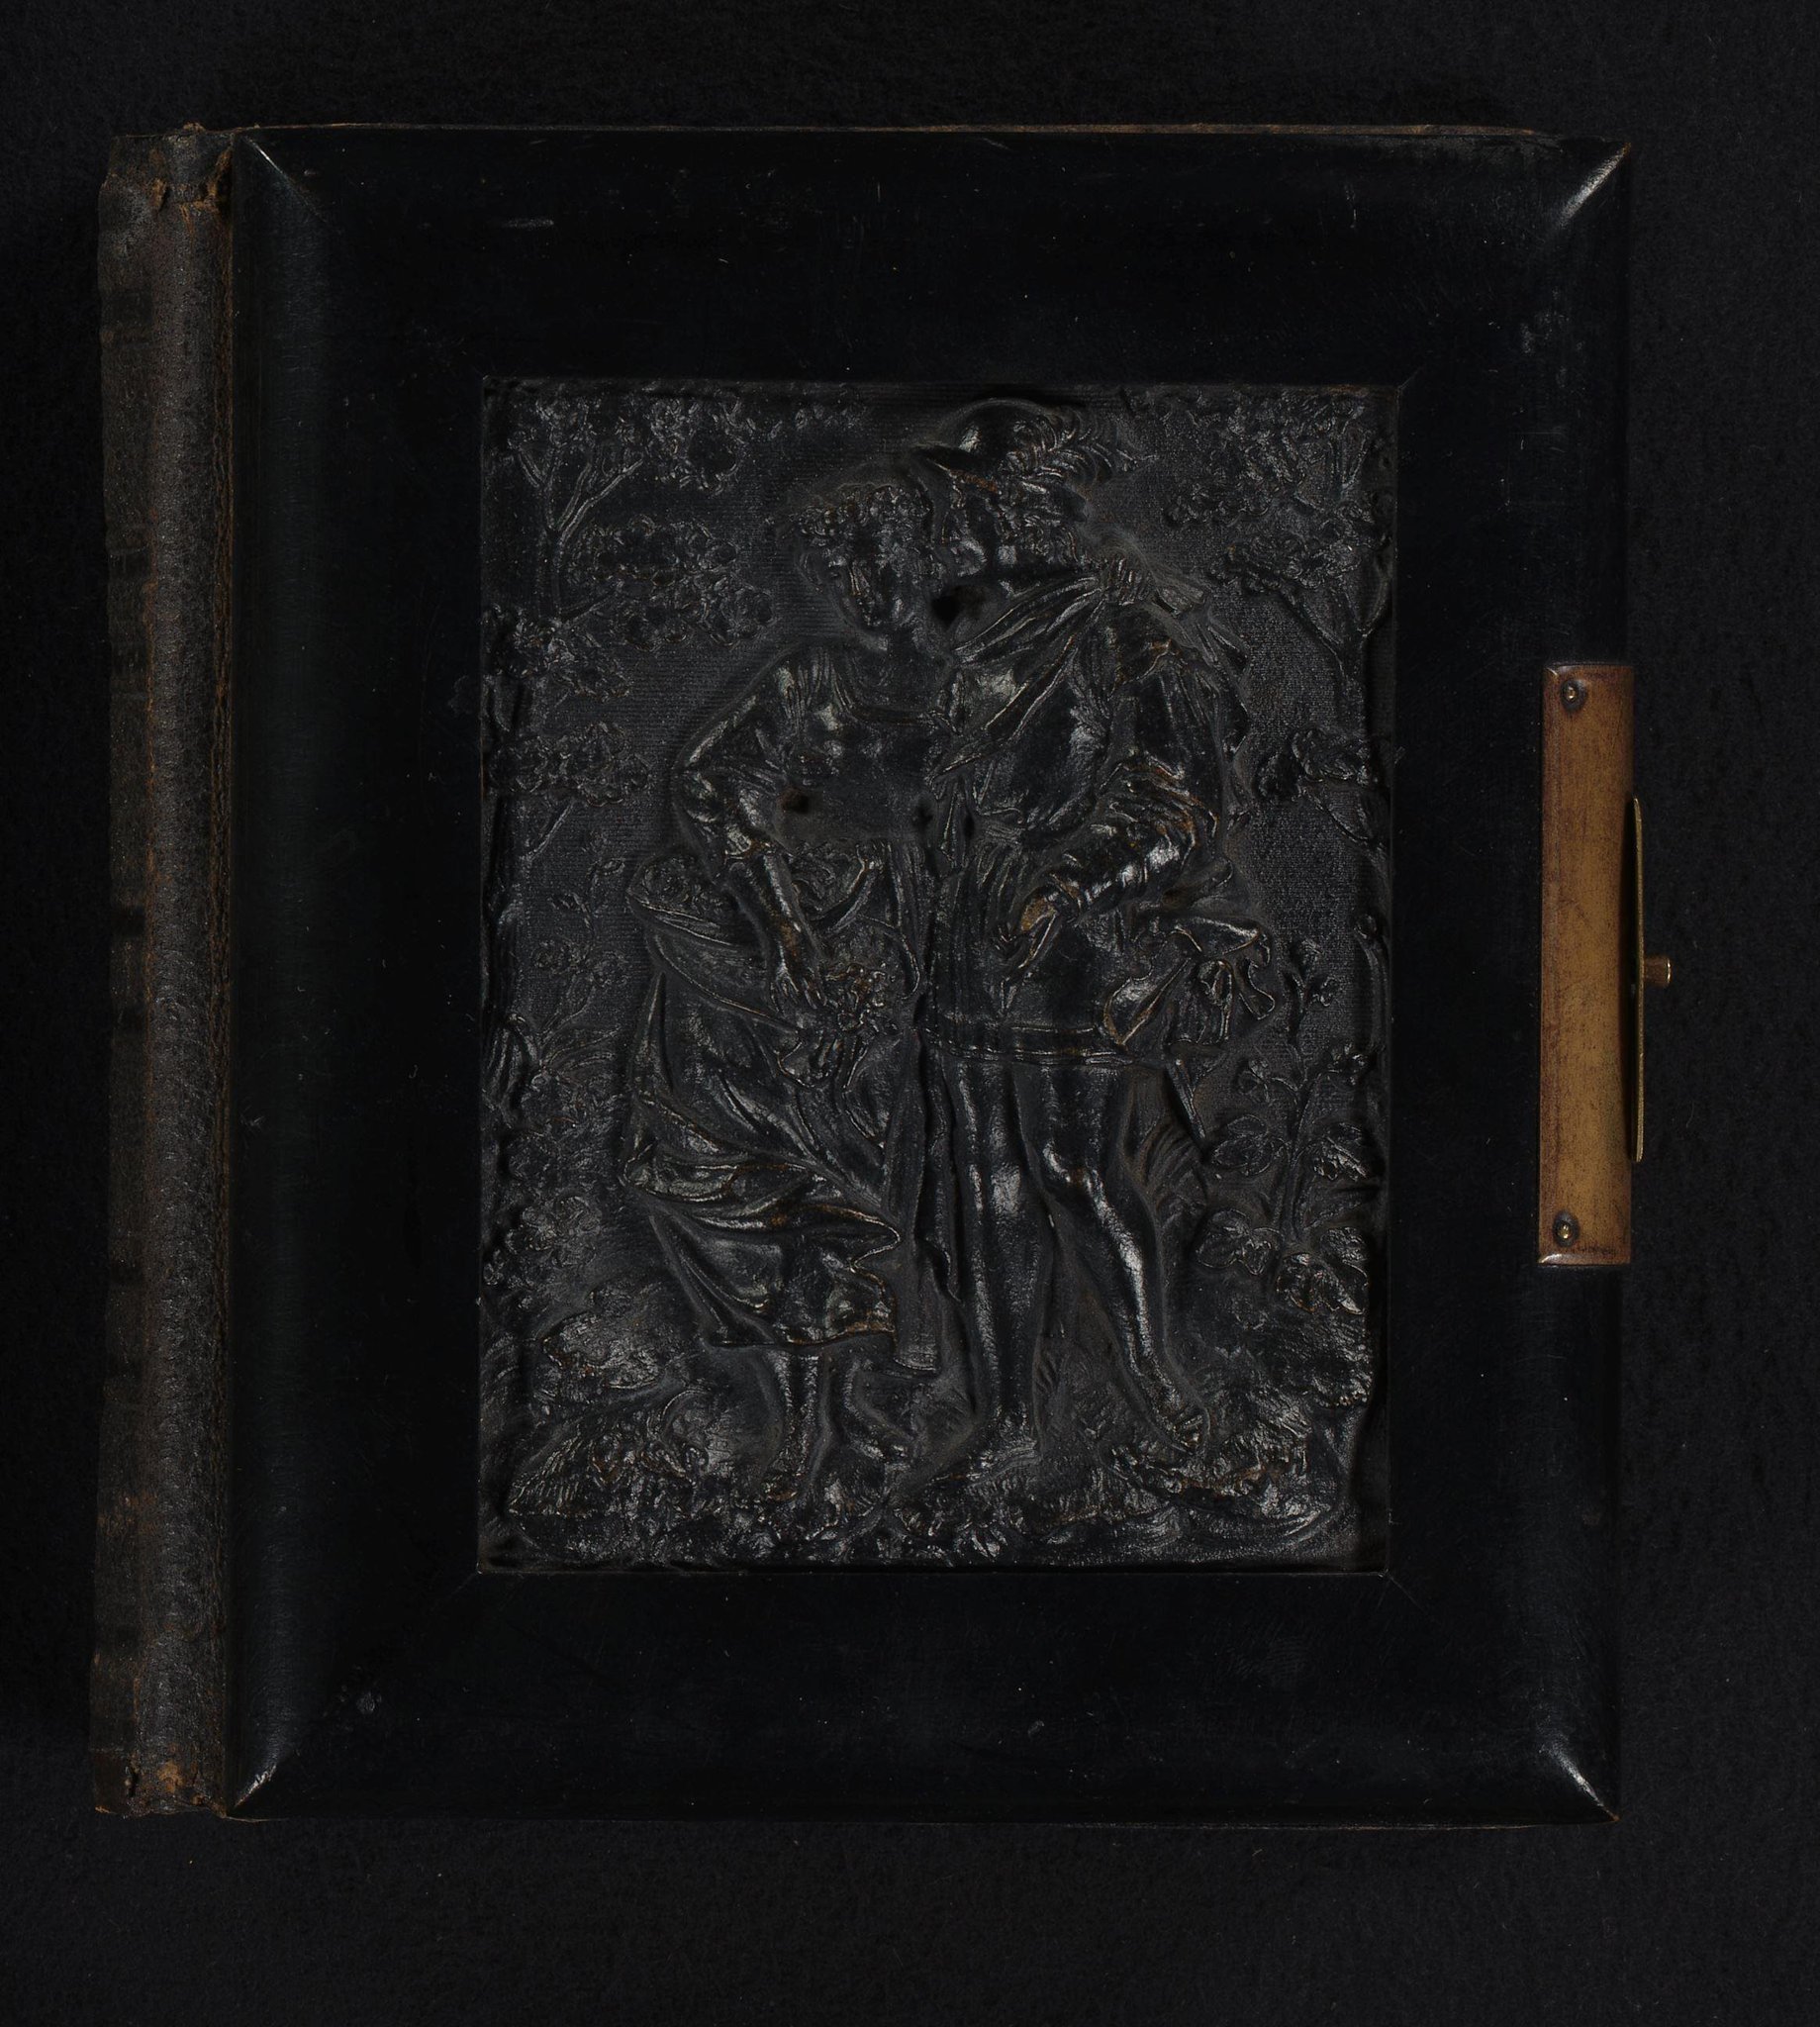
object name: slip in album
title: Fotoalbum (leeg)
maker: Anonymous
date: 1860-1900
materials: cardboard, metal, paper, wood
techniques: color on snow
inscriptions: collector's mark: ‘DIENST/ VERSPREIDE/ RIJKSKOLLEKTIES/ (...) A 734’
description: Fotoalbum met 48 pagina's met op iedere pagina een rechthoekige of ovale passe-partout, met gouden lijnen omkaderd, voor een carte-de-visite.